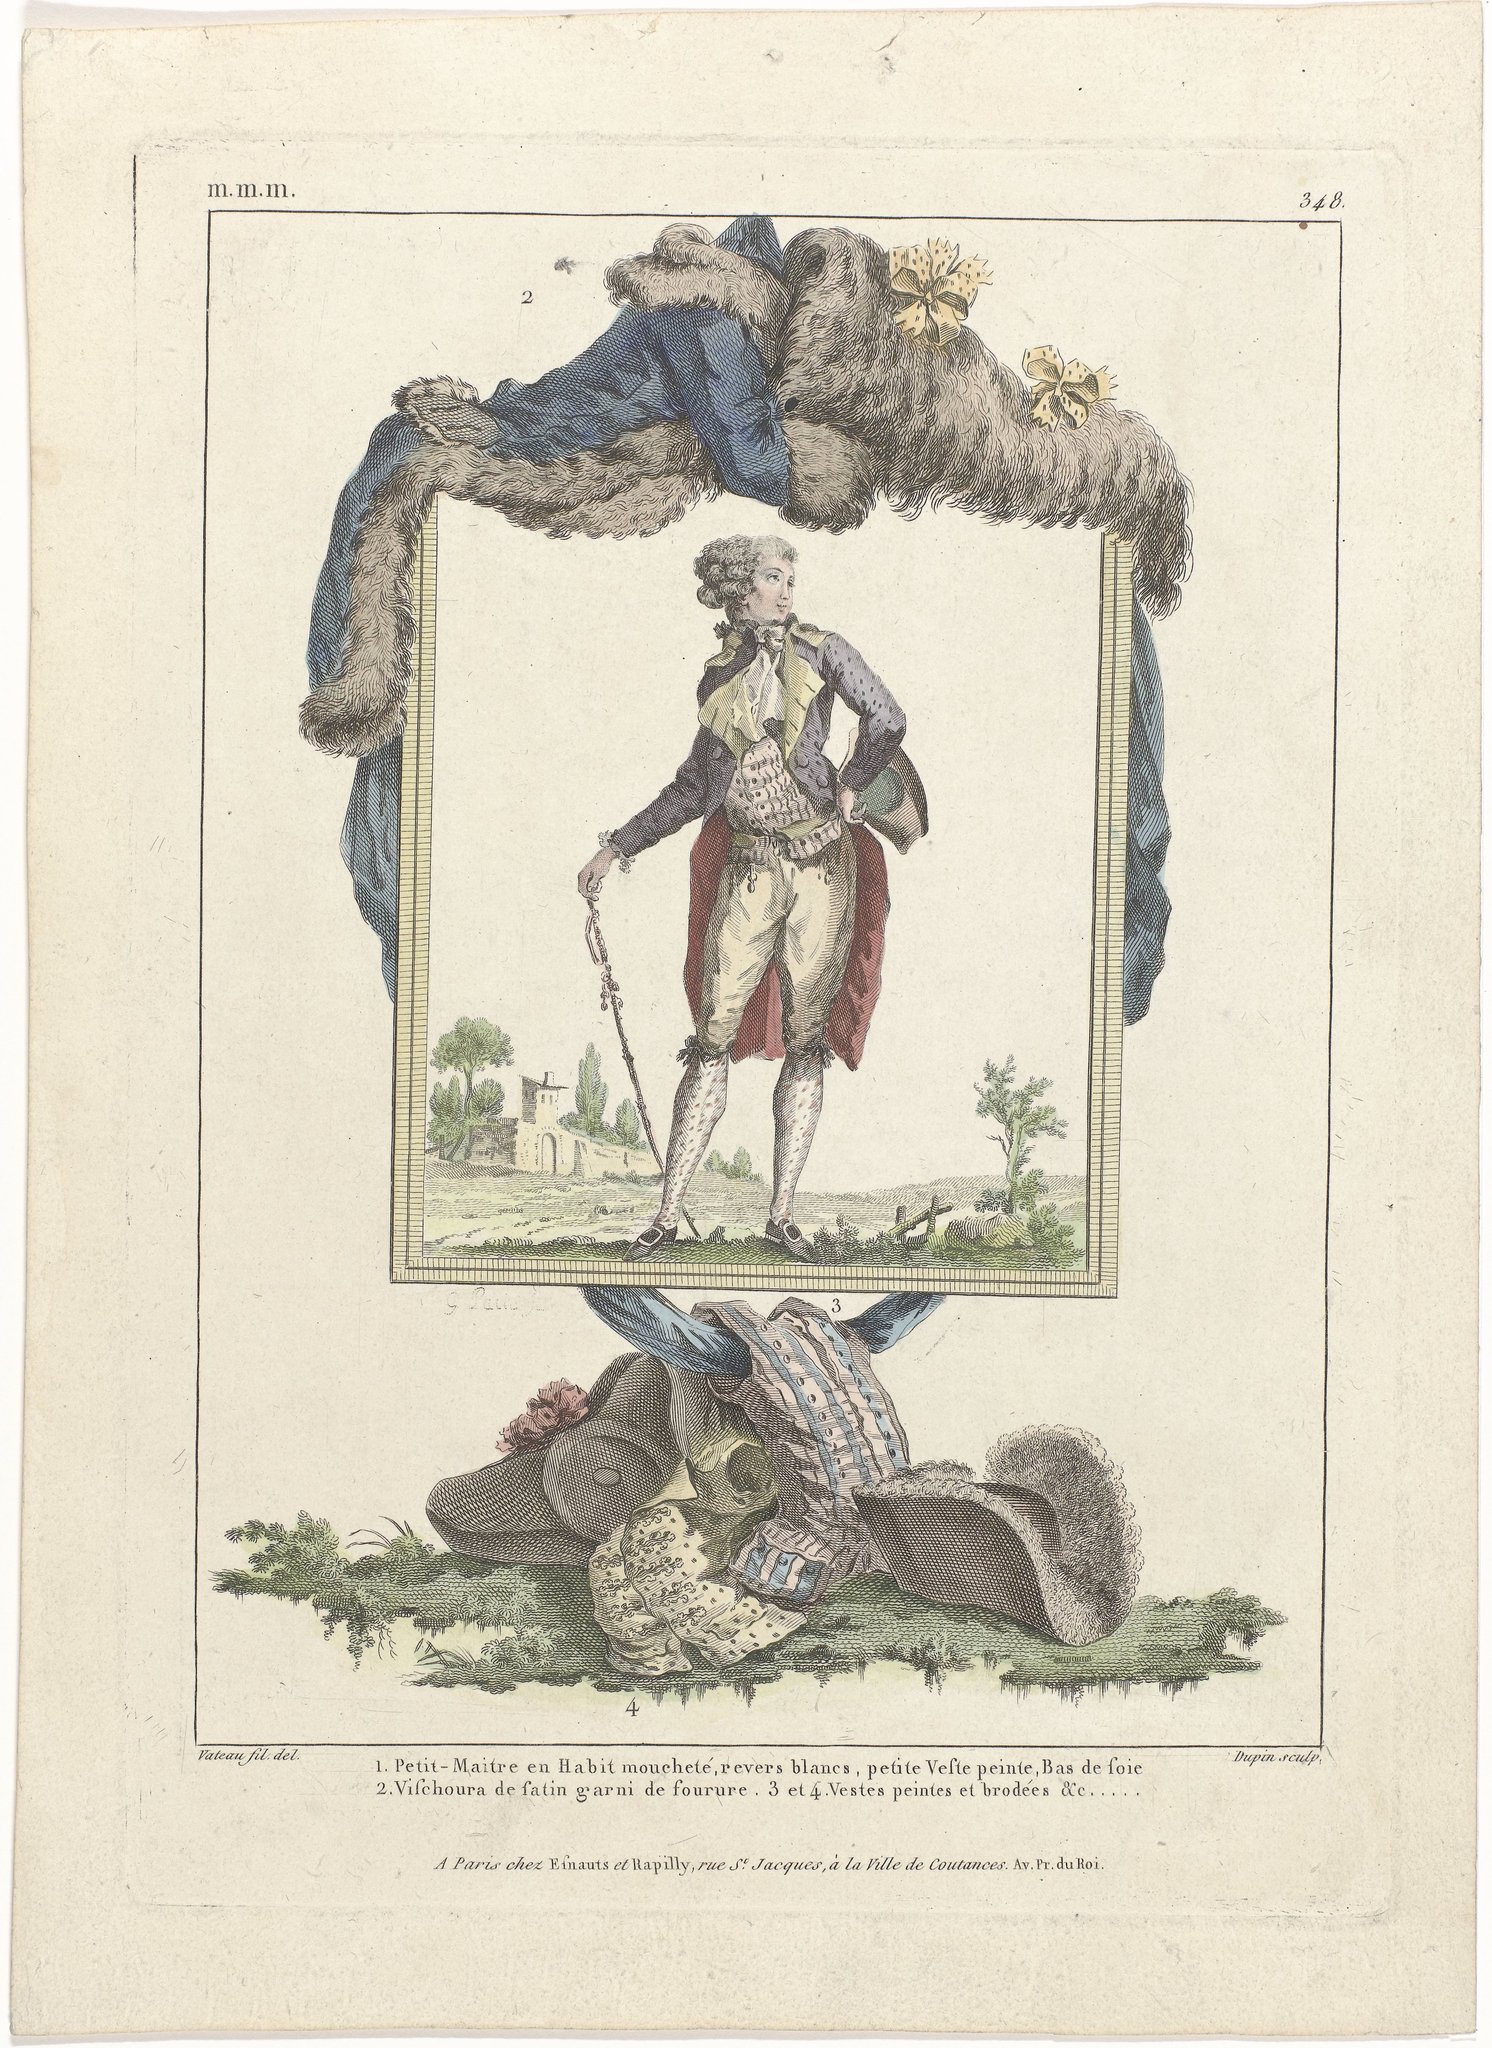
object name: fashion print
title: Gallerie des Modes et Costumes Français, 1787, mmm 348 : 1. Petit Maître en Habit moucheté (...)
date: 1787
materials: paper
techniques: engraving, hand coloring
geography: paris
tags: clothing for the upper part of the body (vest) (+ men's clothes), dandy, beau, embroidery (ornamentation) (+ men's clothes), neck-gear ~ clothing (revers) (+ men's clothes), coat (+ men's clothes), head-gear: hat (+ men's clothes), fashion plates, trousers, breeches, etc. (breeches) (+ men's clothes), stockings, socks (+ men's clothes), walking-stick, staff, cane (+ men's clothes)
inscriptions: caption: ‘1. Petit Maître en Habit moucheté, revers blancs, petite Veste peinte, Bas de soie 2. Vischoura de satin garni de fourure. 3 et 4. Vestes peintes et brodées &c.....’, address: ‘A Paris chez Esnauts et Rapilly, rue St. Jacques, à la Ville de Coutances, Av. Pr. du Roi.’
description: Petit Maître gekleed in een gestippelde habit met witte revers op een kort gekleurd vest en kniebroek. Gestippelde kousen van zijde. Accesssoires: hoed, breloques, wandelstok, schoenen met gespen. Boven het kader een 'vischoura' (jas) van satijn gegarneerd met bont en een grote mof van bont met twee strikken van gestippeld lint. Onder het kader liggen twee beschilderde en geborduurde vesten en twee mannenhoeden. Prent uit de serie mmm. 55e Cahier de Costumes Français, 49e Suite d'Habillements à la mode en 1787, Gallerie des Modes et Costumes Français